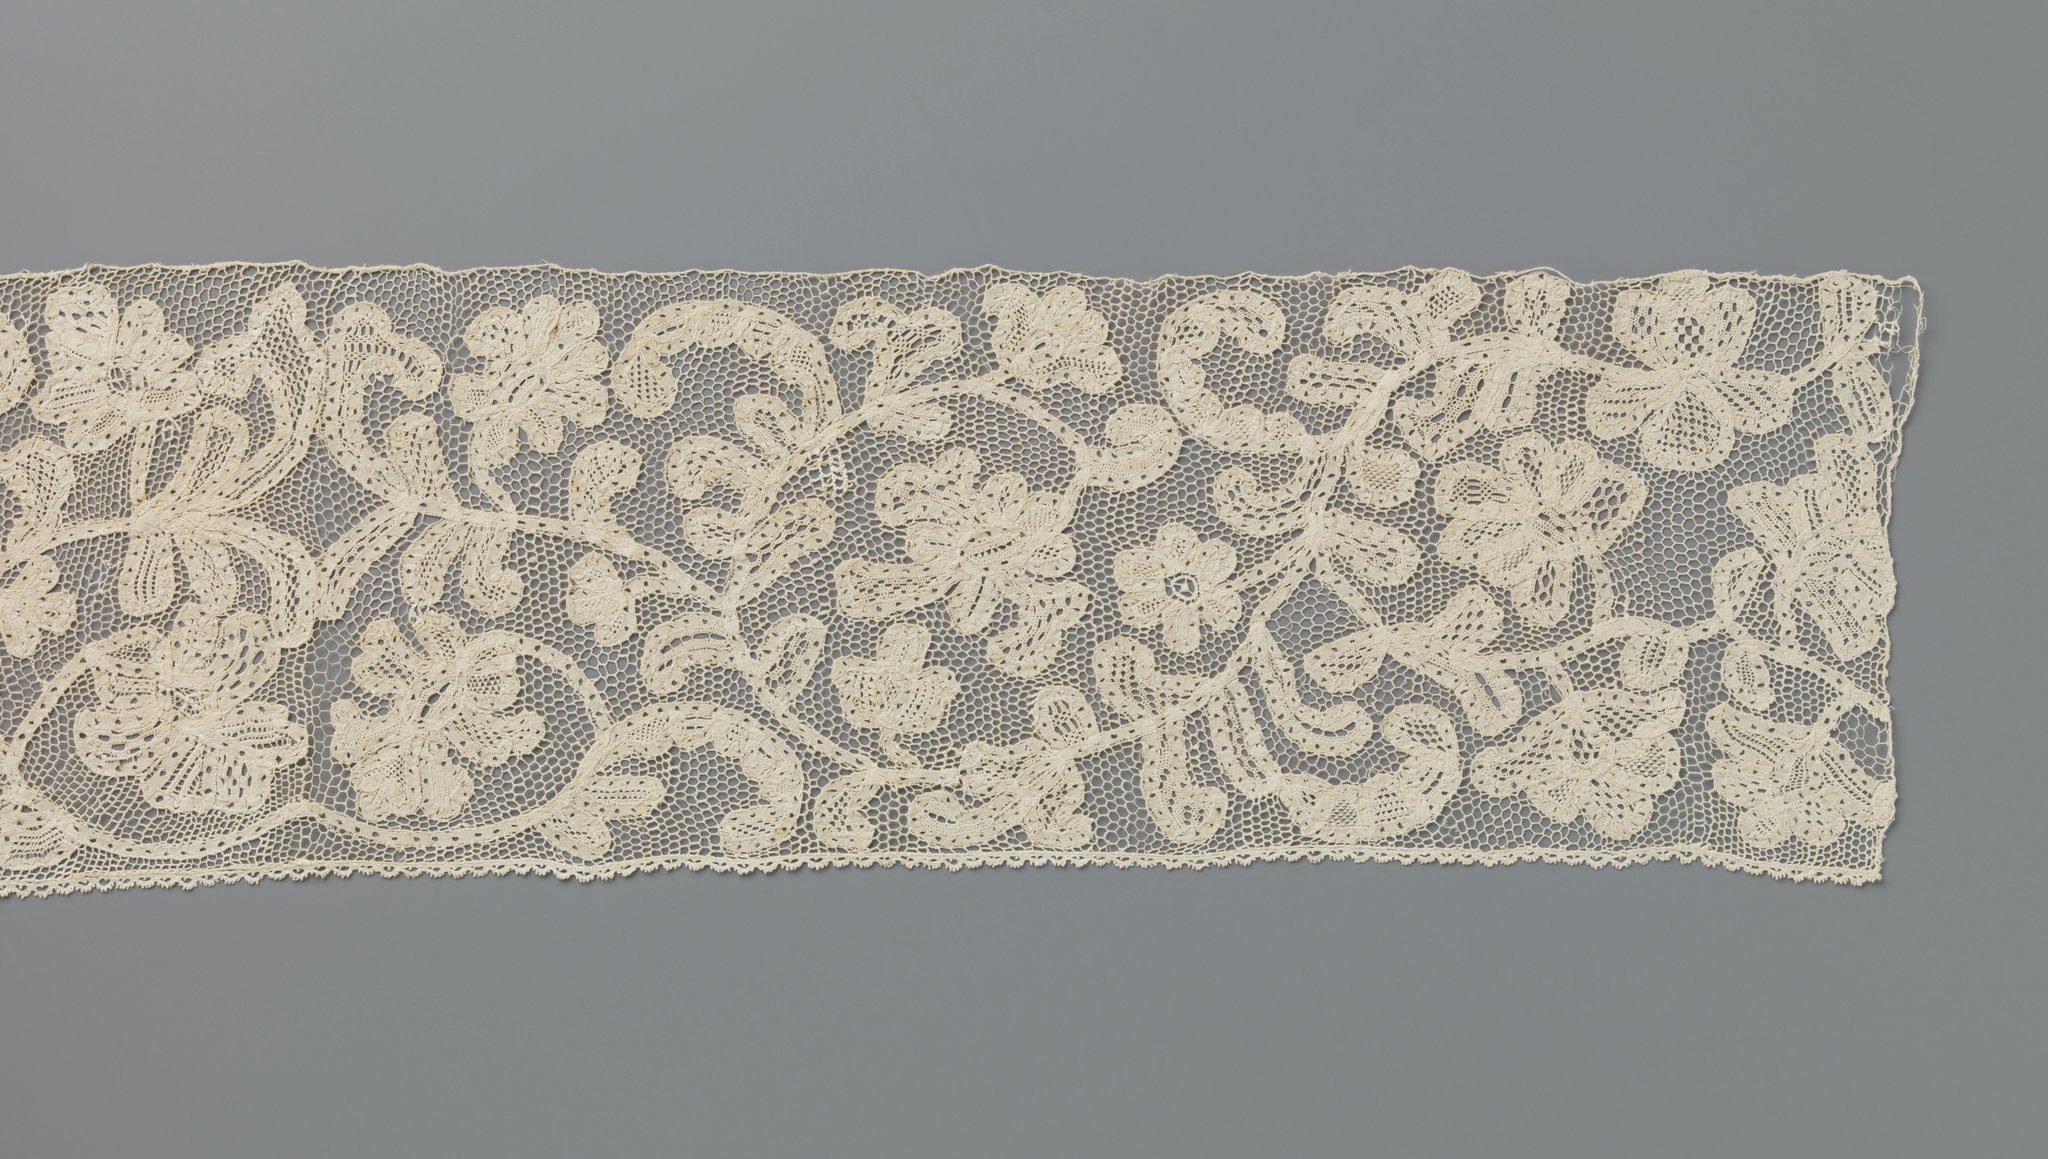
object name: albestrook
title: Strook gemengde kant voor een superplie met voluutranken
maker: Anonymous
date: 1640-1660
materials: linen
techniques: lace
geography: venice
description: Strook naturelkleurige gemengde kant: mezzo punto. De strook is bestemd voor een superplie en heeft een symmetrisch patroon van voluutranken, met rozetbloemen, waaiervormige bloemen en acanthusbladeren op een zeshoekige maasgrond (naaldkant). De contouren van het patroon worden gevormd door een geklost lint met gaatjes. Binnen de contouren verschillende naaldkant siergronden. Strook met drie naden. De bovenzijde is afgewerkt met een rechte rand. De onderzijde en zijkanten zijn afgezet met een rechte rand kloskant met gepicoteerde boogjes.